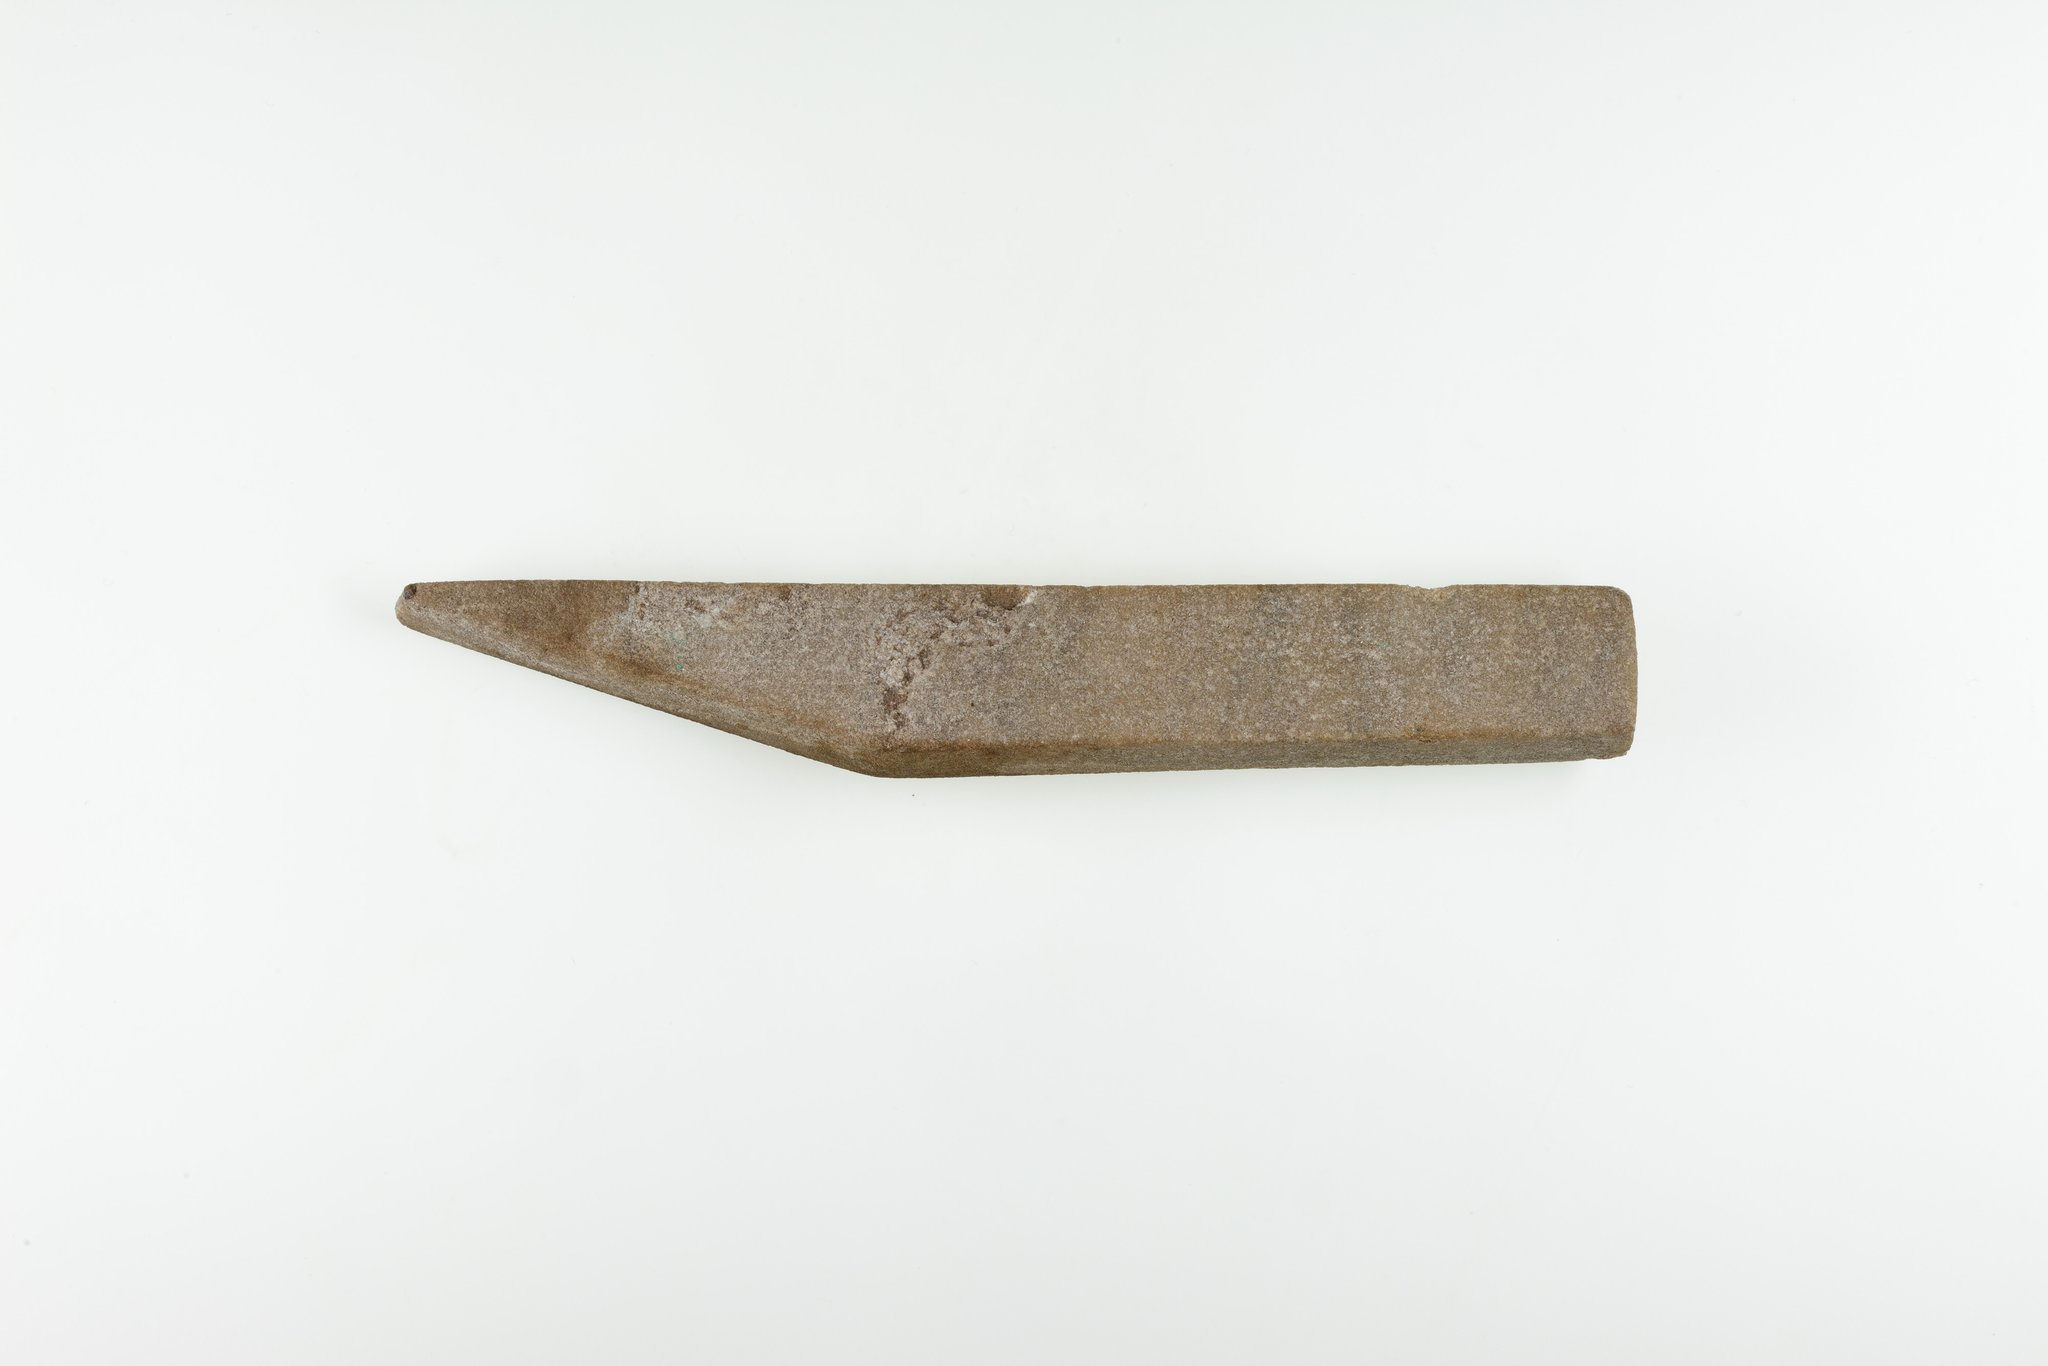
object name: whetstone, baki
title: Whetstone of Baki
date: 1504-1447 BCE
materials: stone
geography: egypt